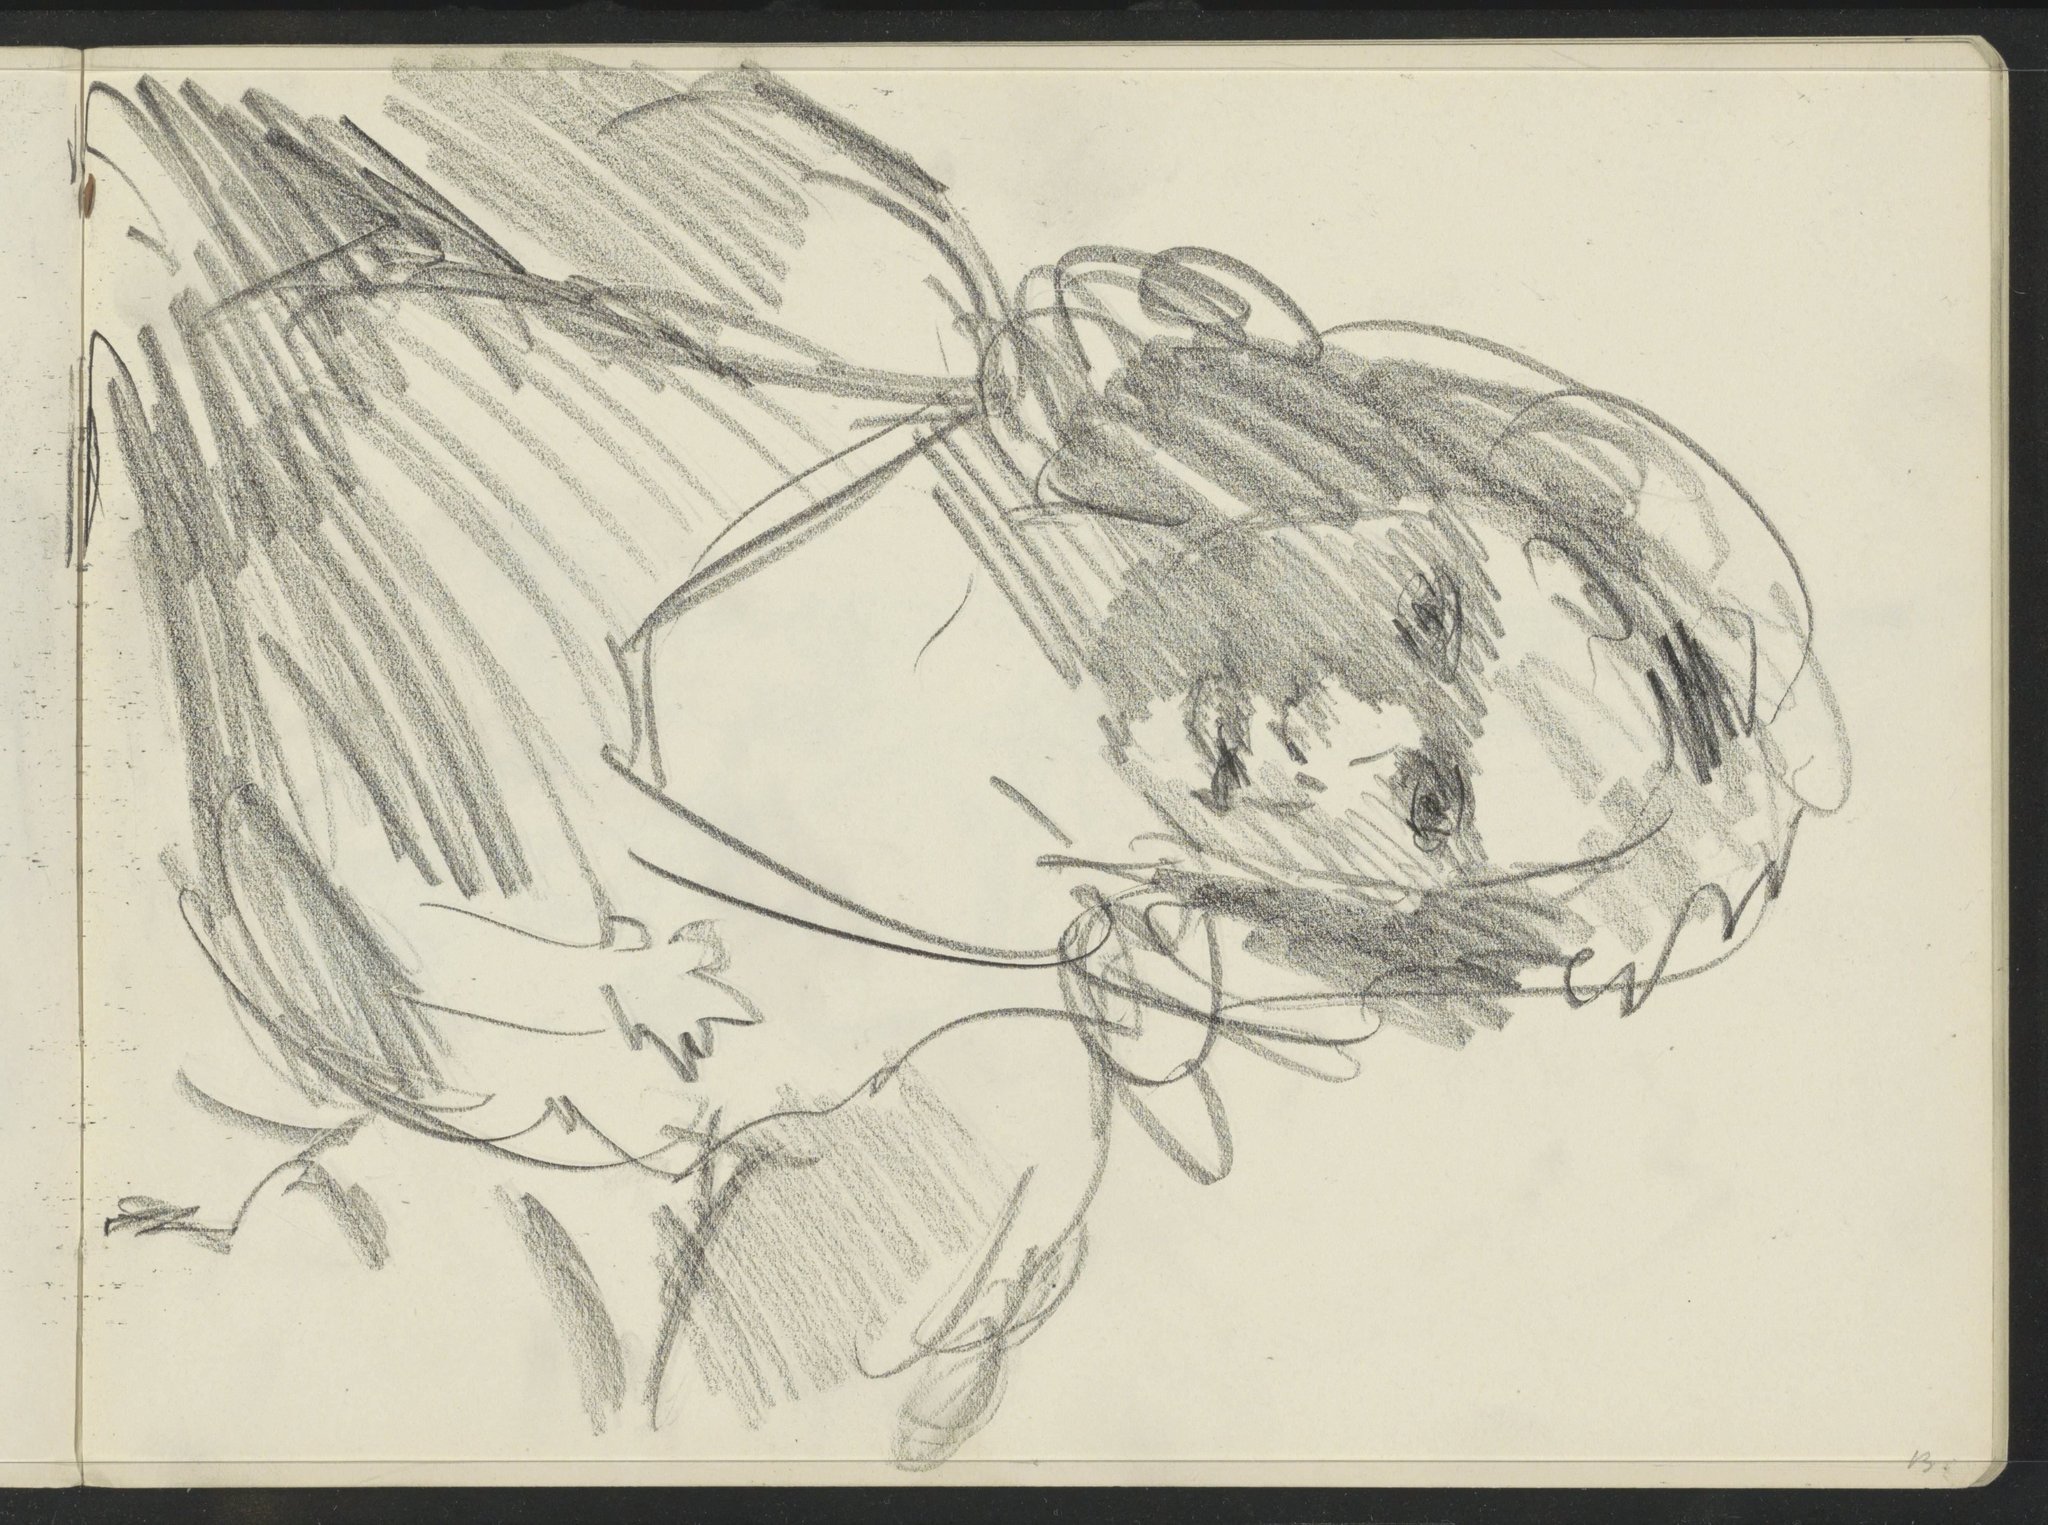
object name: sketchbook leaf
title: Vrouw, ten halven lijve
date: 1915-1934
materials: paper, pencil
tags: adult woman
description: Blad 13 recto uit schetsboek XVI met 32 bladen.